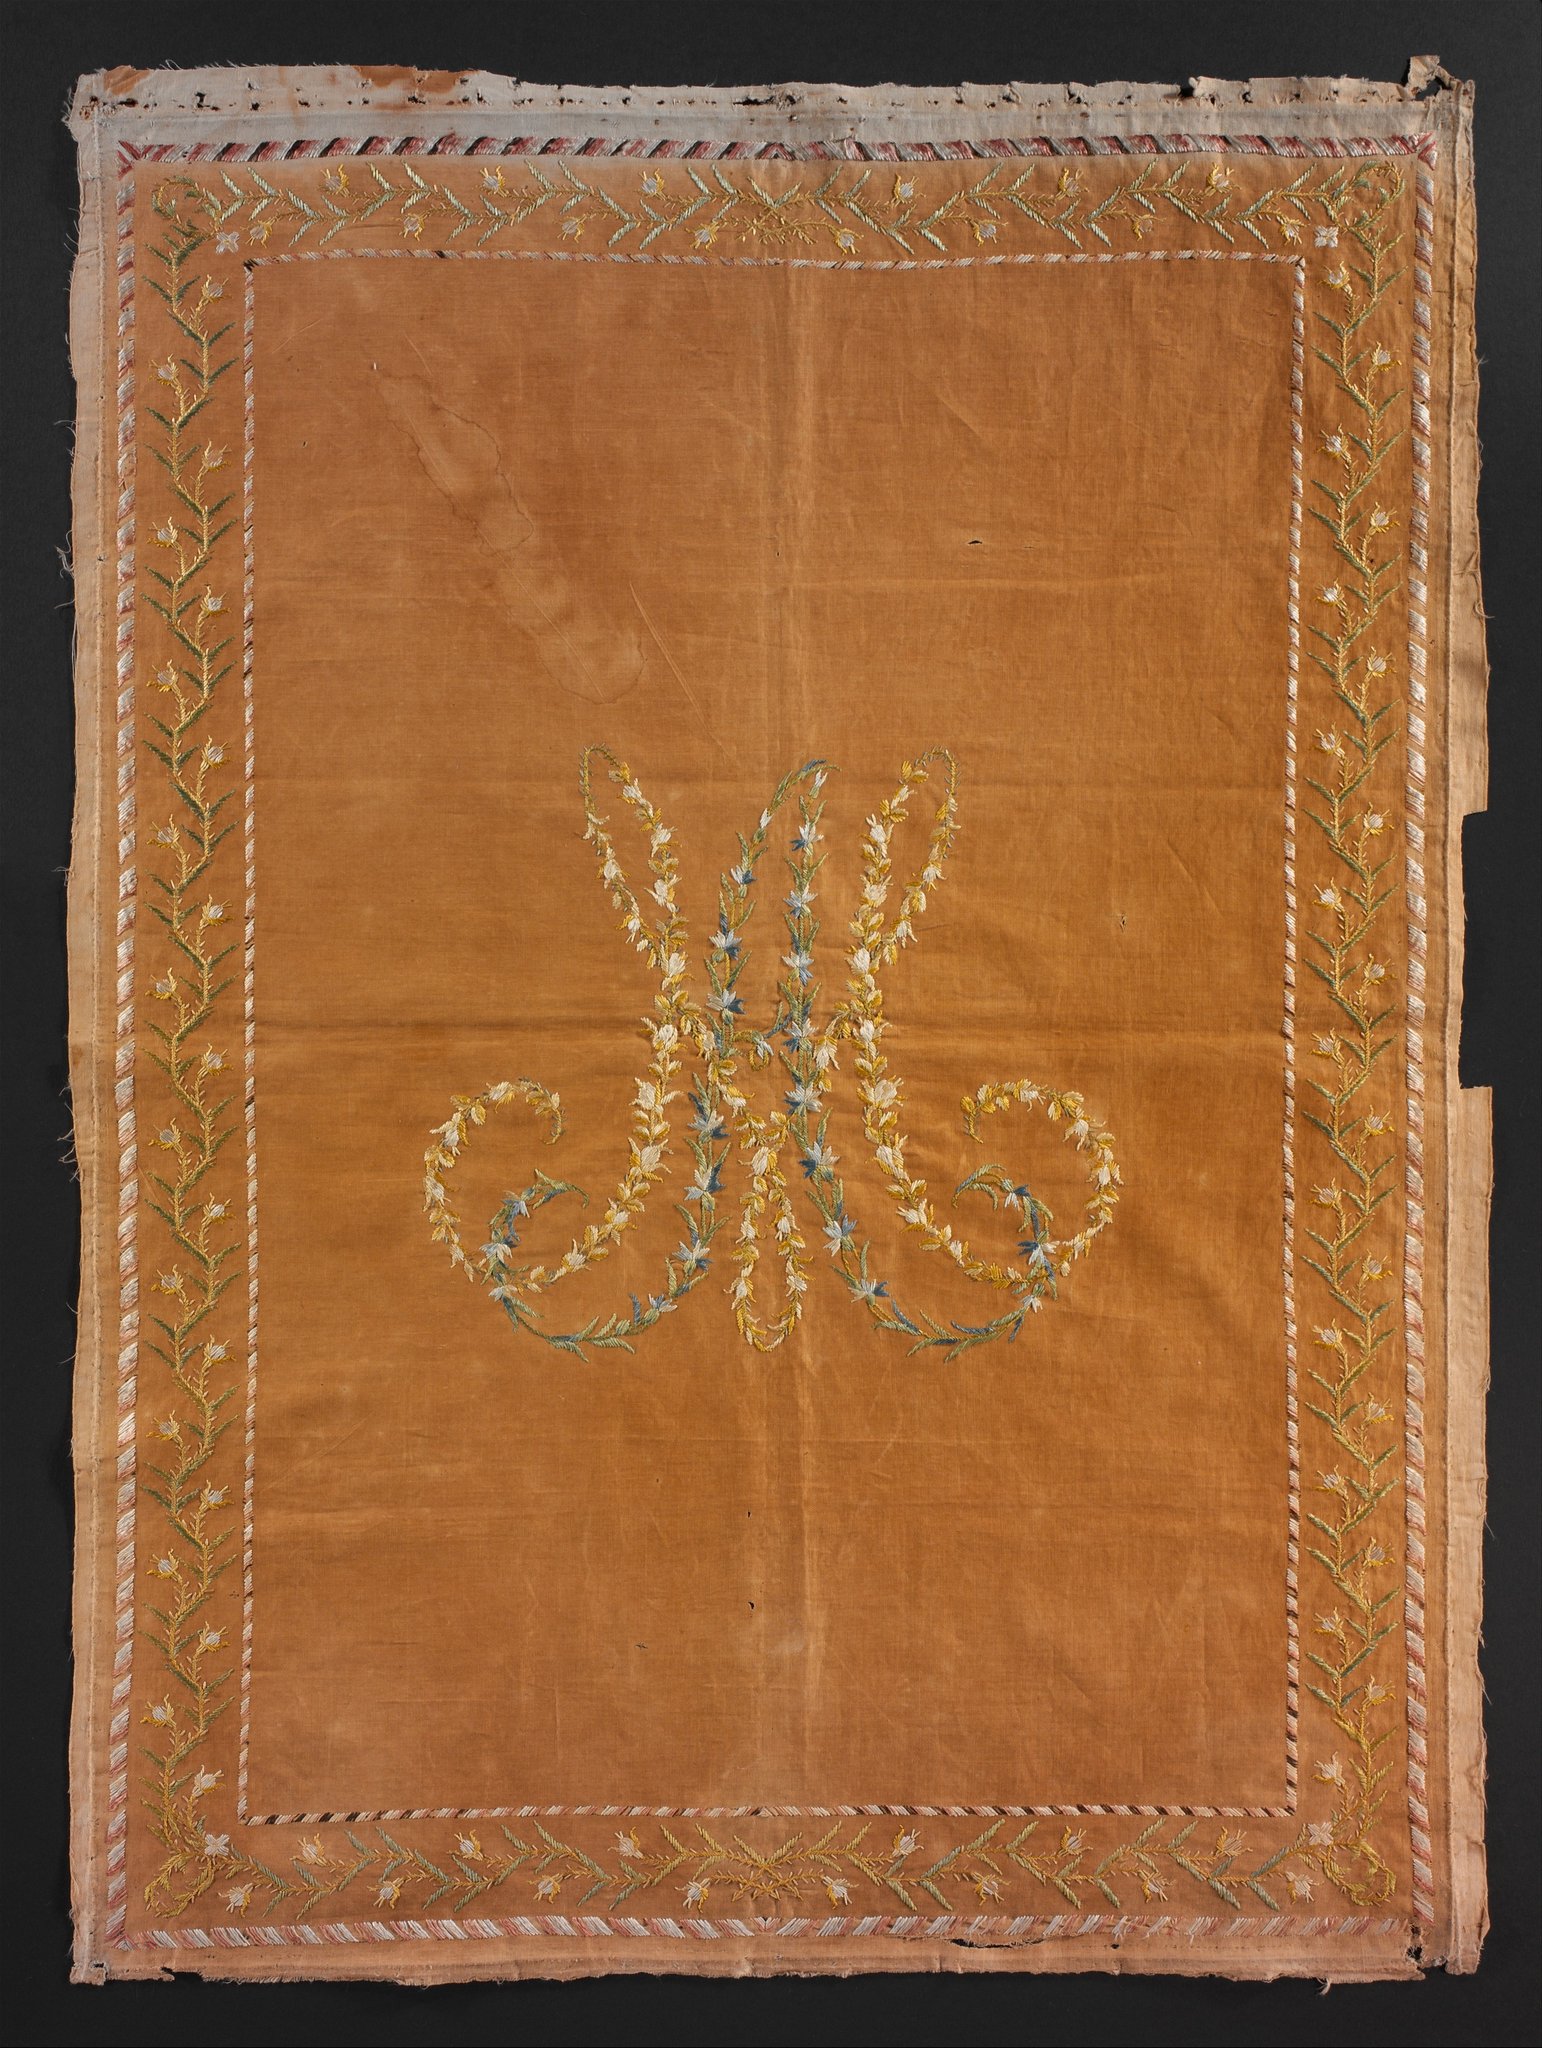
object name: panel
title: Firescreen panel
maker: marie antoinette, queen of france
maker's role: maker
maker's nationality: french, born austria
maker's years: 1755-1792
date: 1788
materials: cotton, silk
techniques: embroidery